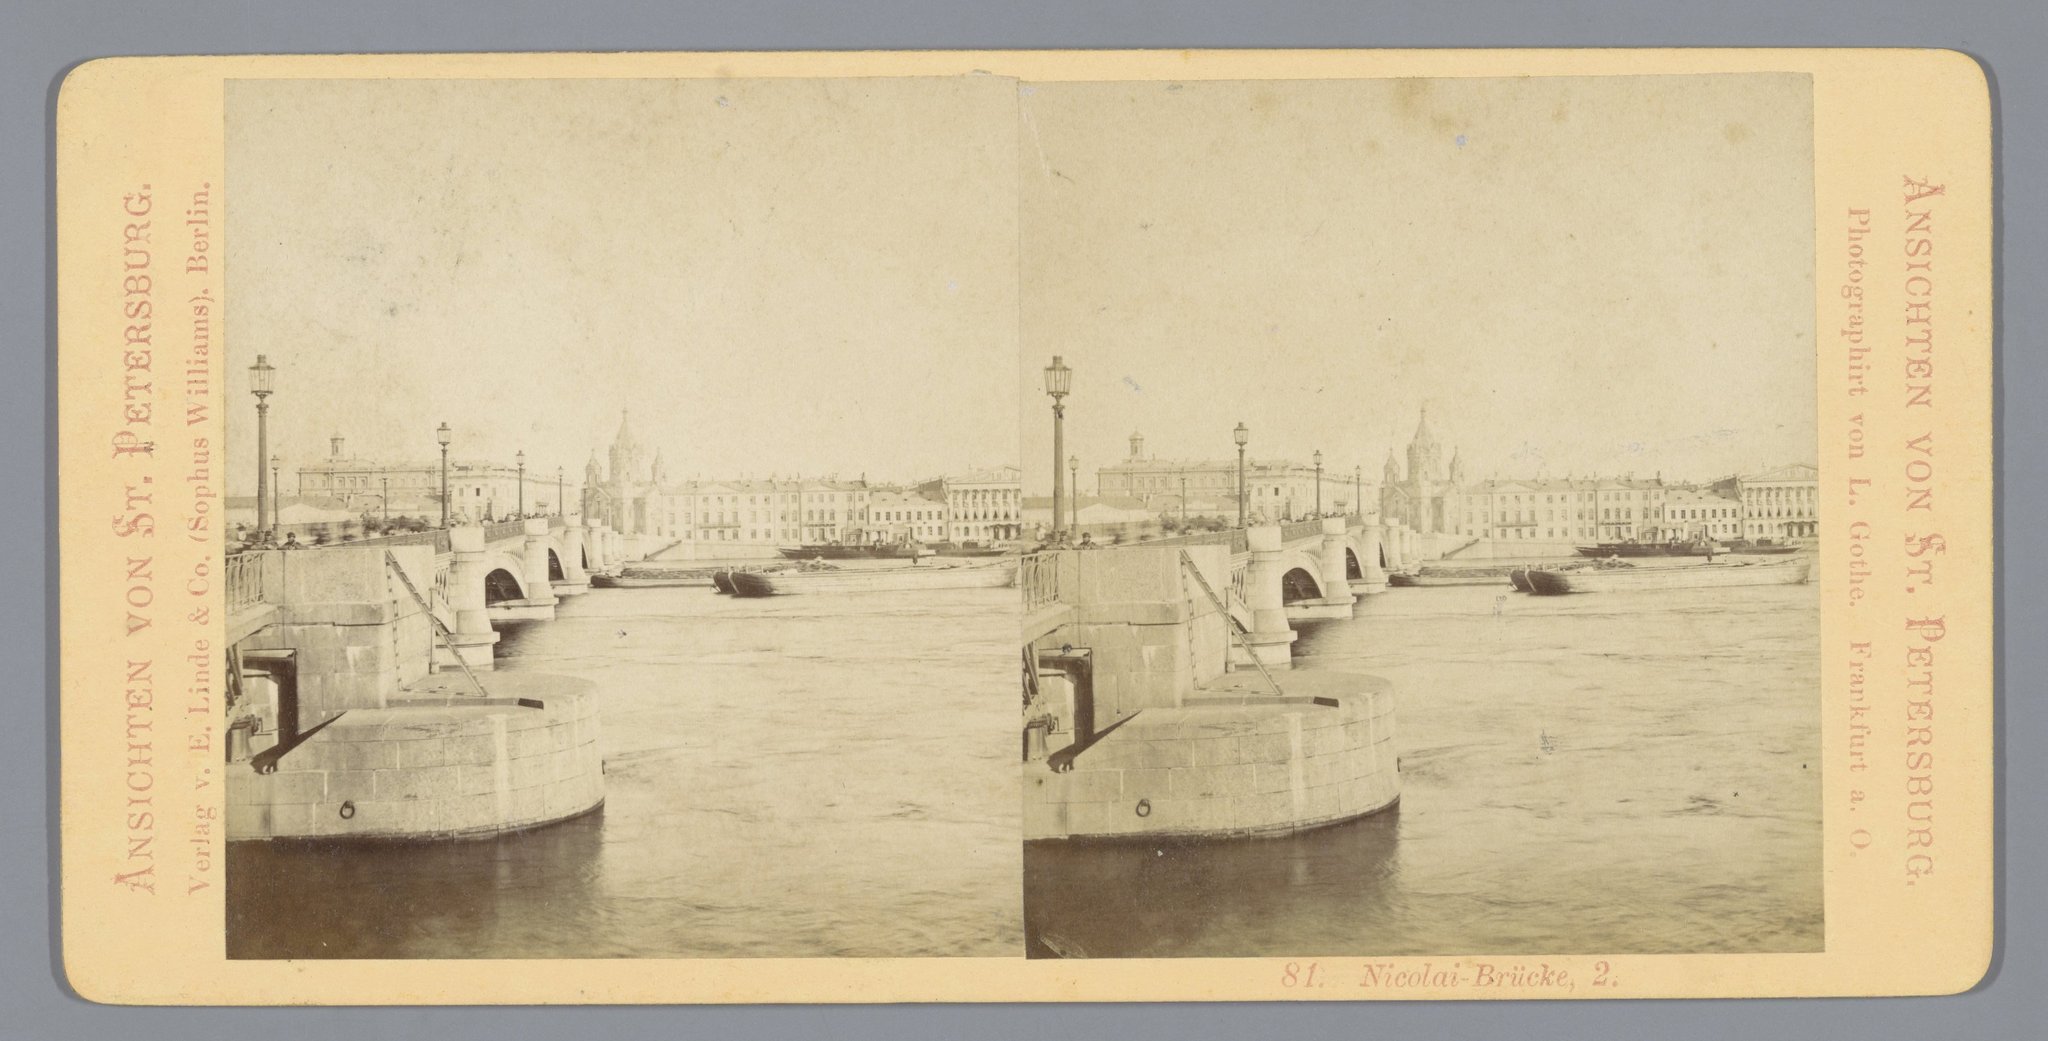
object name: stereograph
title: Gezicht op de Nicolaasbrug in Sint-Petersburg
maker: louis gothe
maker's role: fotograaf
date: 1850-1880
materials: cardboard, photographic support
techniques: albumen print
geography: sint-petersburg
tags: bridge in city across river, canal, etc.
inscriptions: inscription: ‘Ansichten von St. Petersburg.’, number: ‘81.’